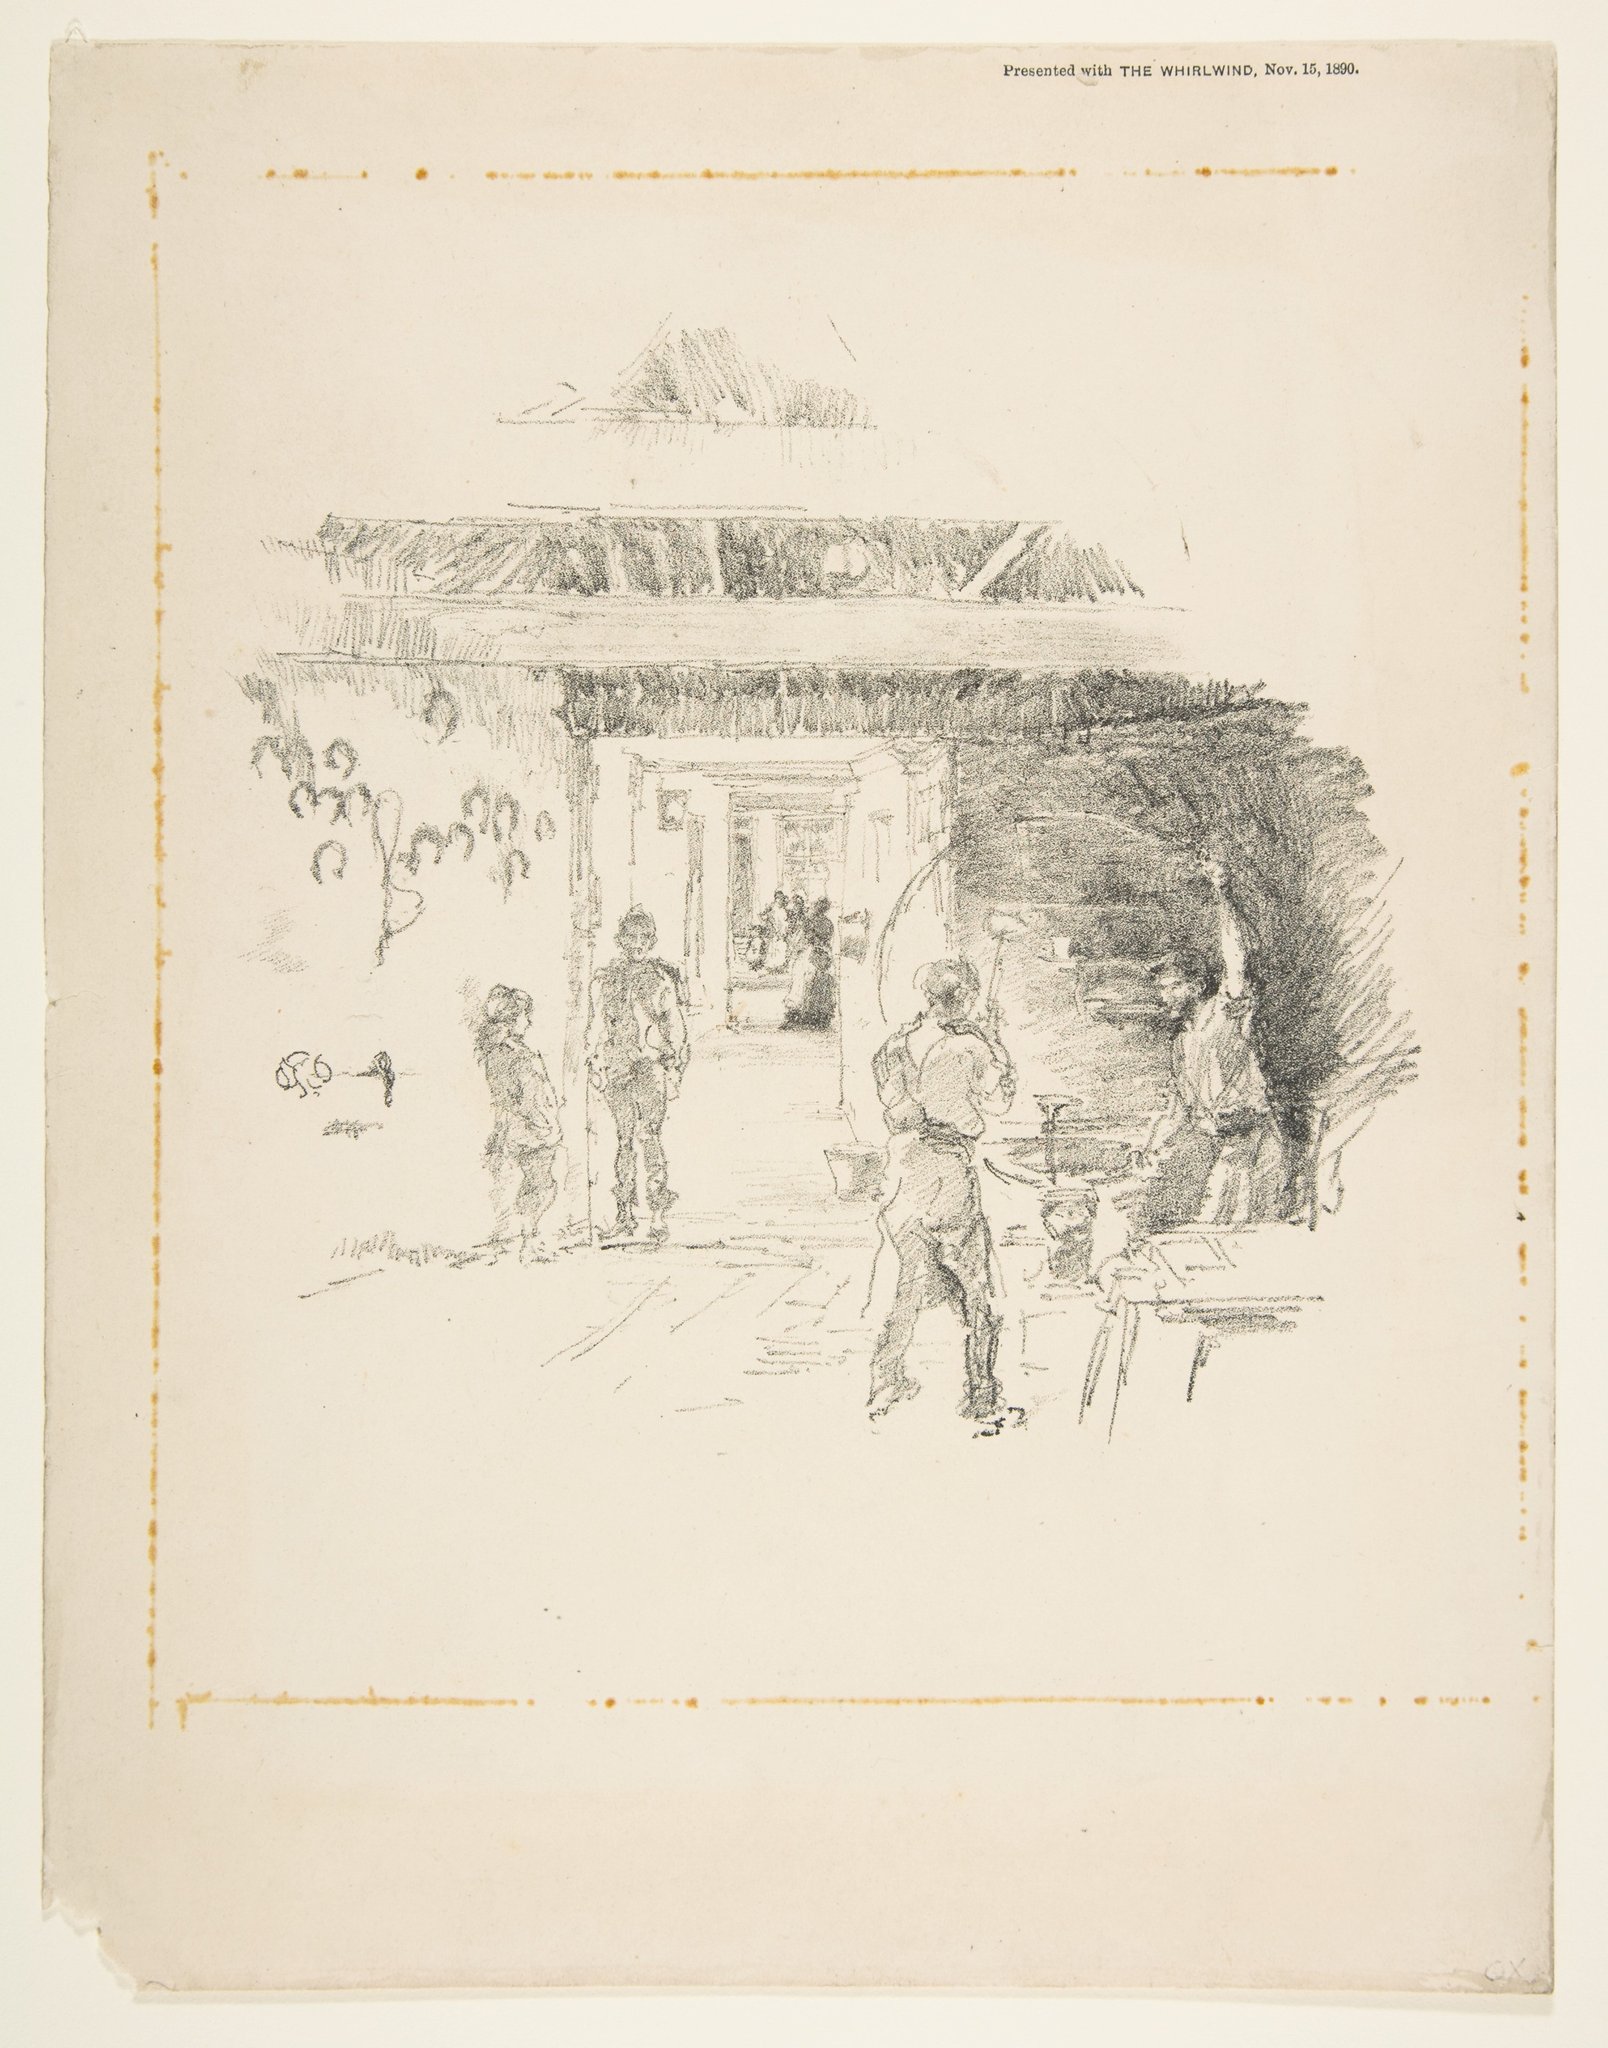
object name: print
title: The Tyresmith, from "The Whirlwind"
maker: james mcneill whistler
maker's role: artist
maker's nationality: american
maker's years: 1834-1903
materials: ink, paper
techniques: printing, lithography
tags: human figures,working